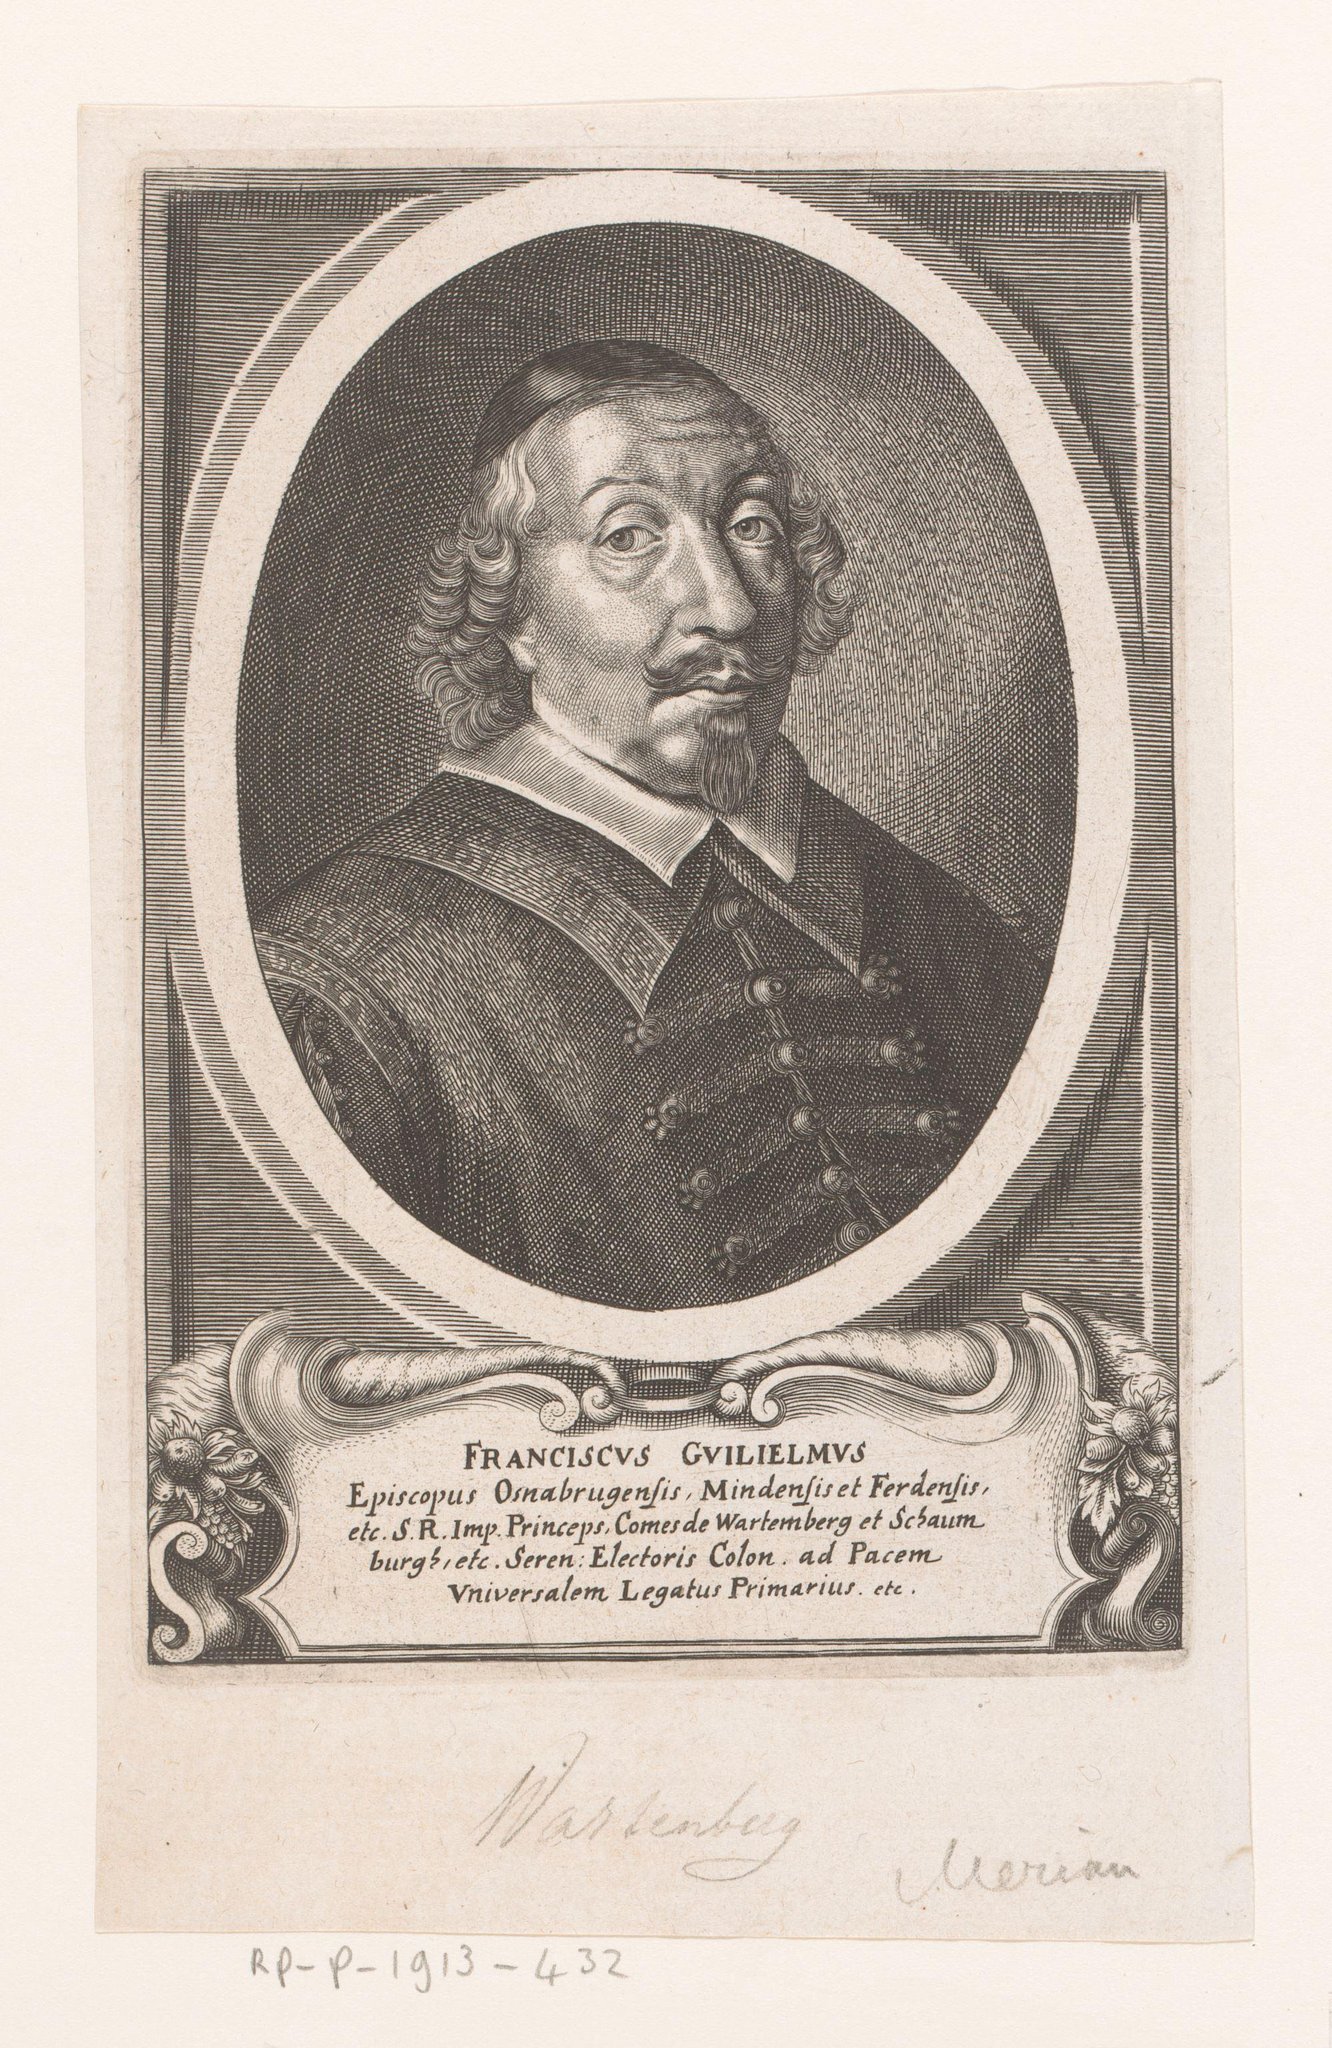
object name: book illustration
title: Portret van Franz Wilhelm von Wartenberg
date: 1652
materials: paper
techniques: engraving, etching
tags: priest, historical persons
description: Illustratie in: J.G. Schleder. Theatrum Europaeum. Dl. 6. Frankfurt a.M., Merian, 1652.